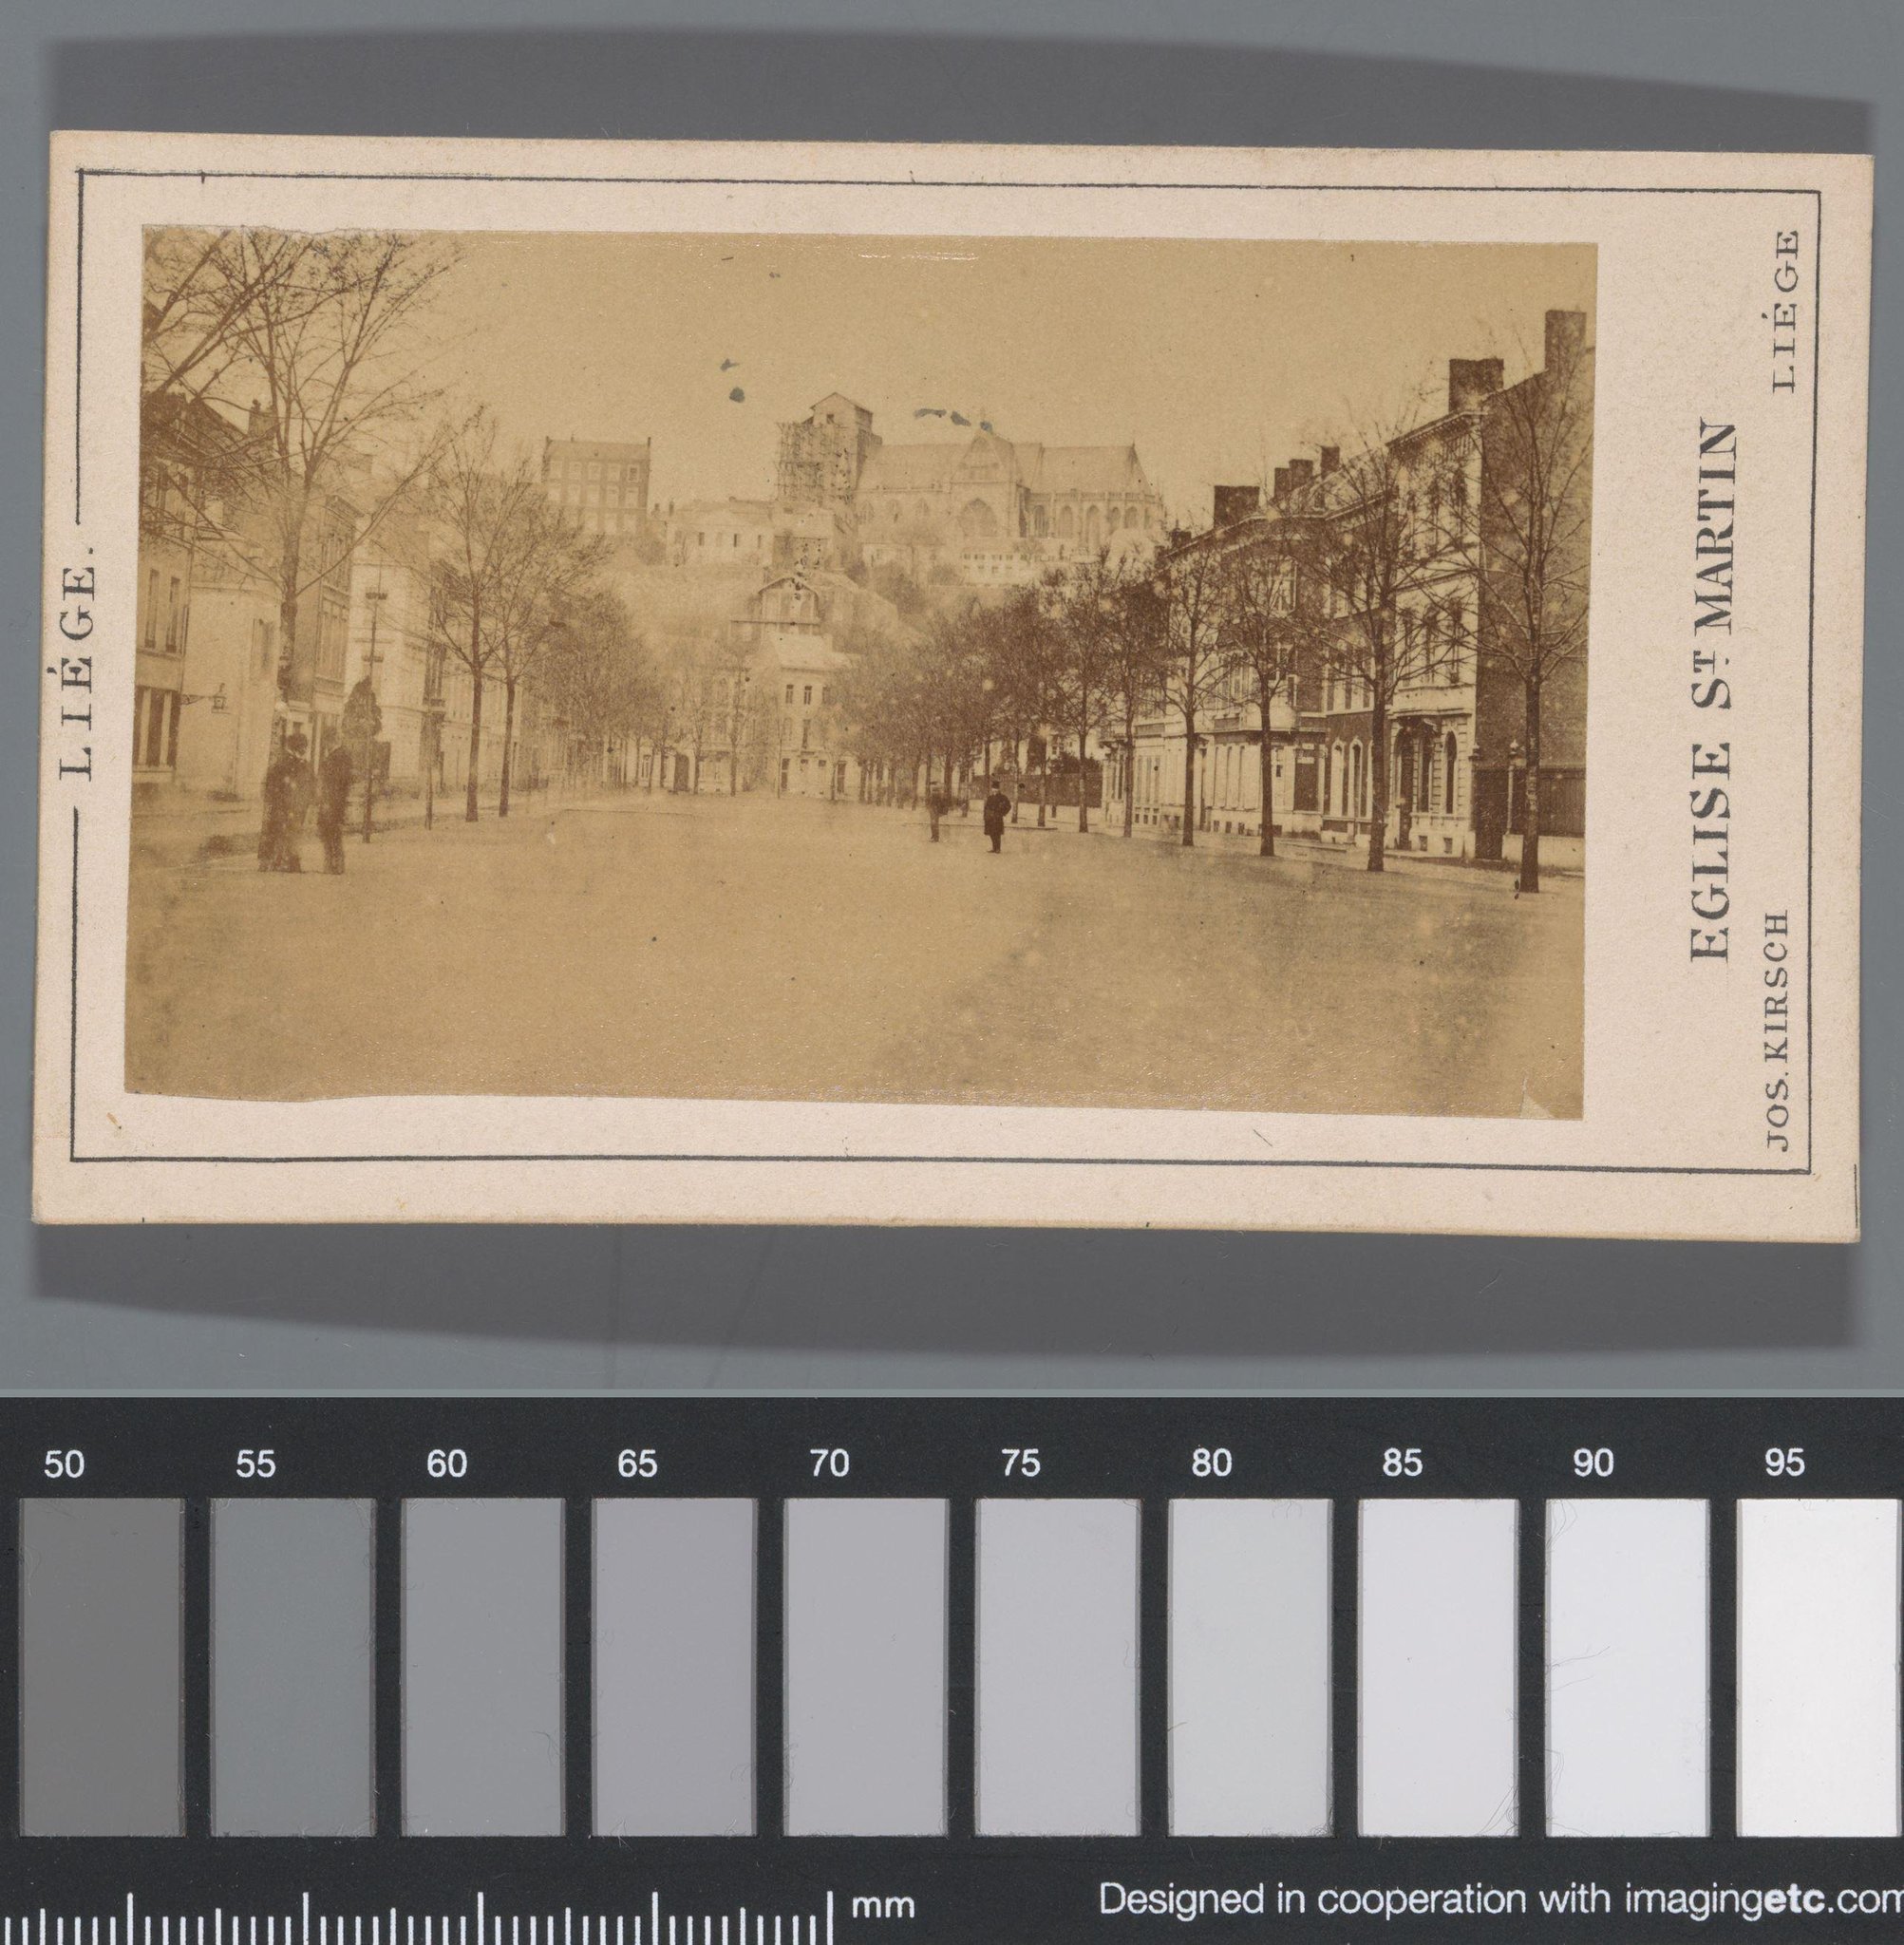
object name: photograph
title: Gezicht op de Boulevard de la Sauvenière en de Sint-Martinusbasiliek, Luik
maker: joseph kirsch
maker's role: fotograaf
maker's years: 1826-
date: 1862-1894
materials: cardboard, paper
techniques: albumen print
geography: liège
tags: avenue, boulevard, promenade, esplanade, liège